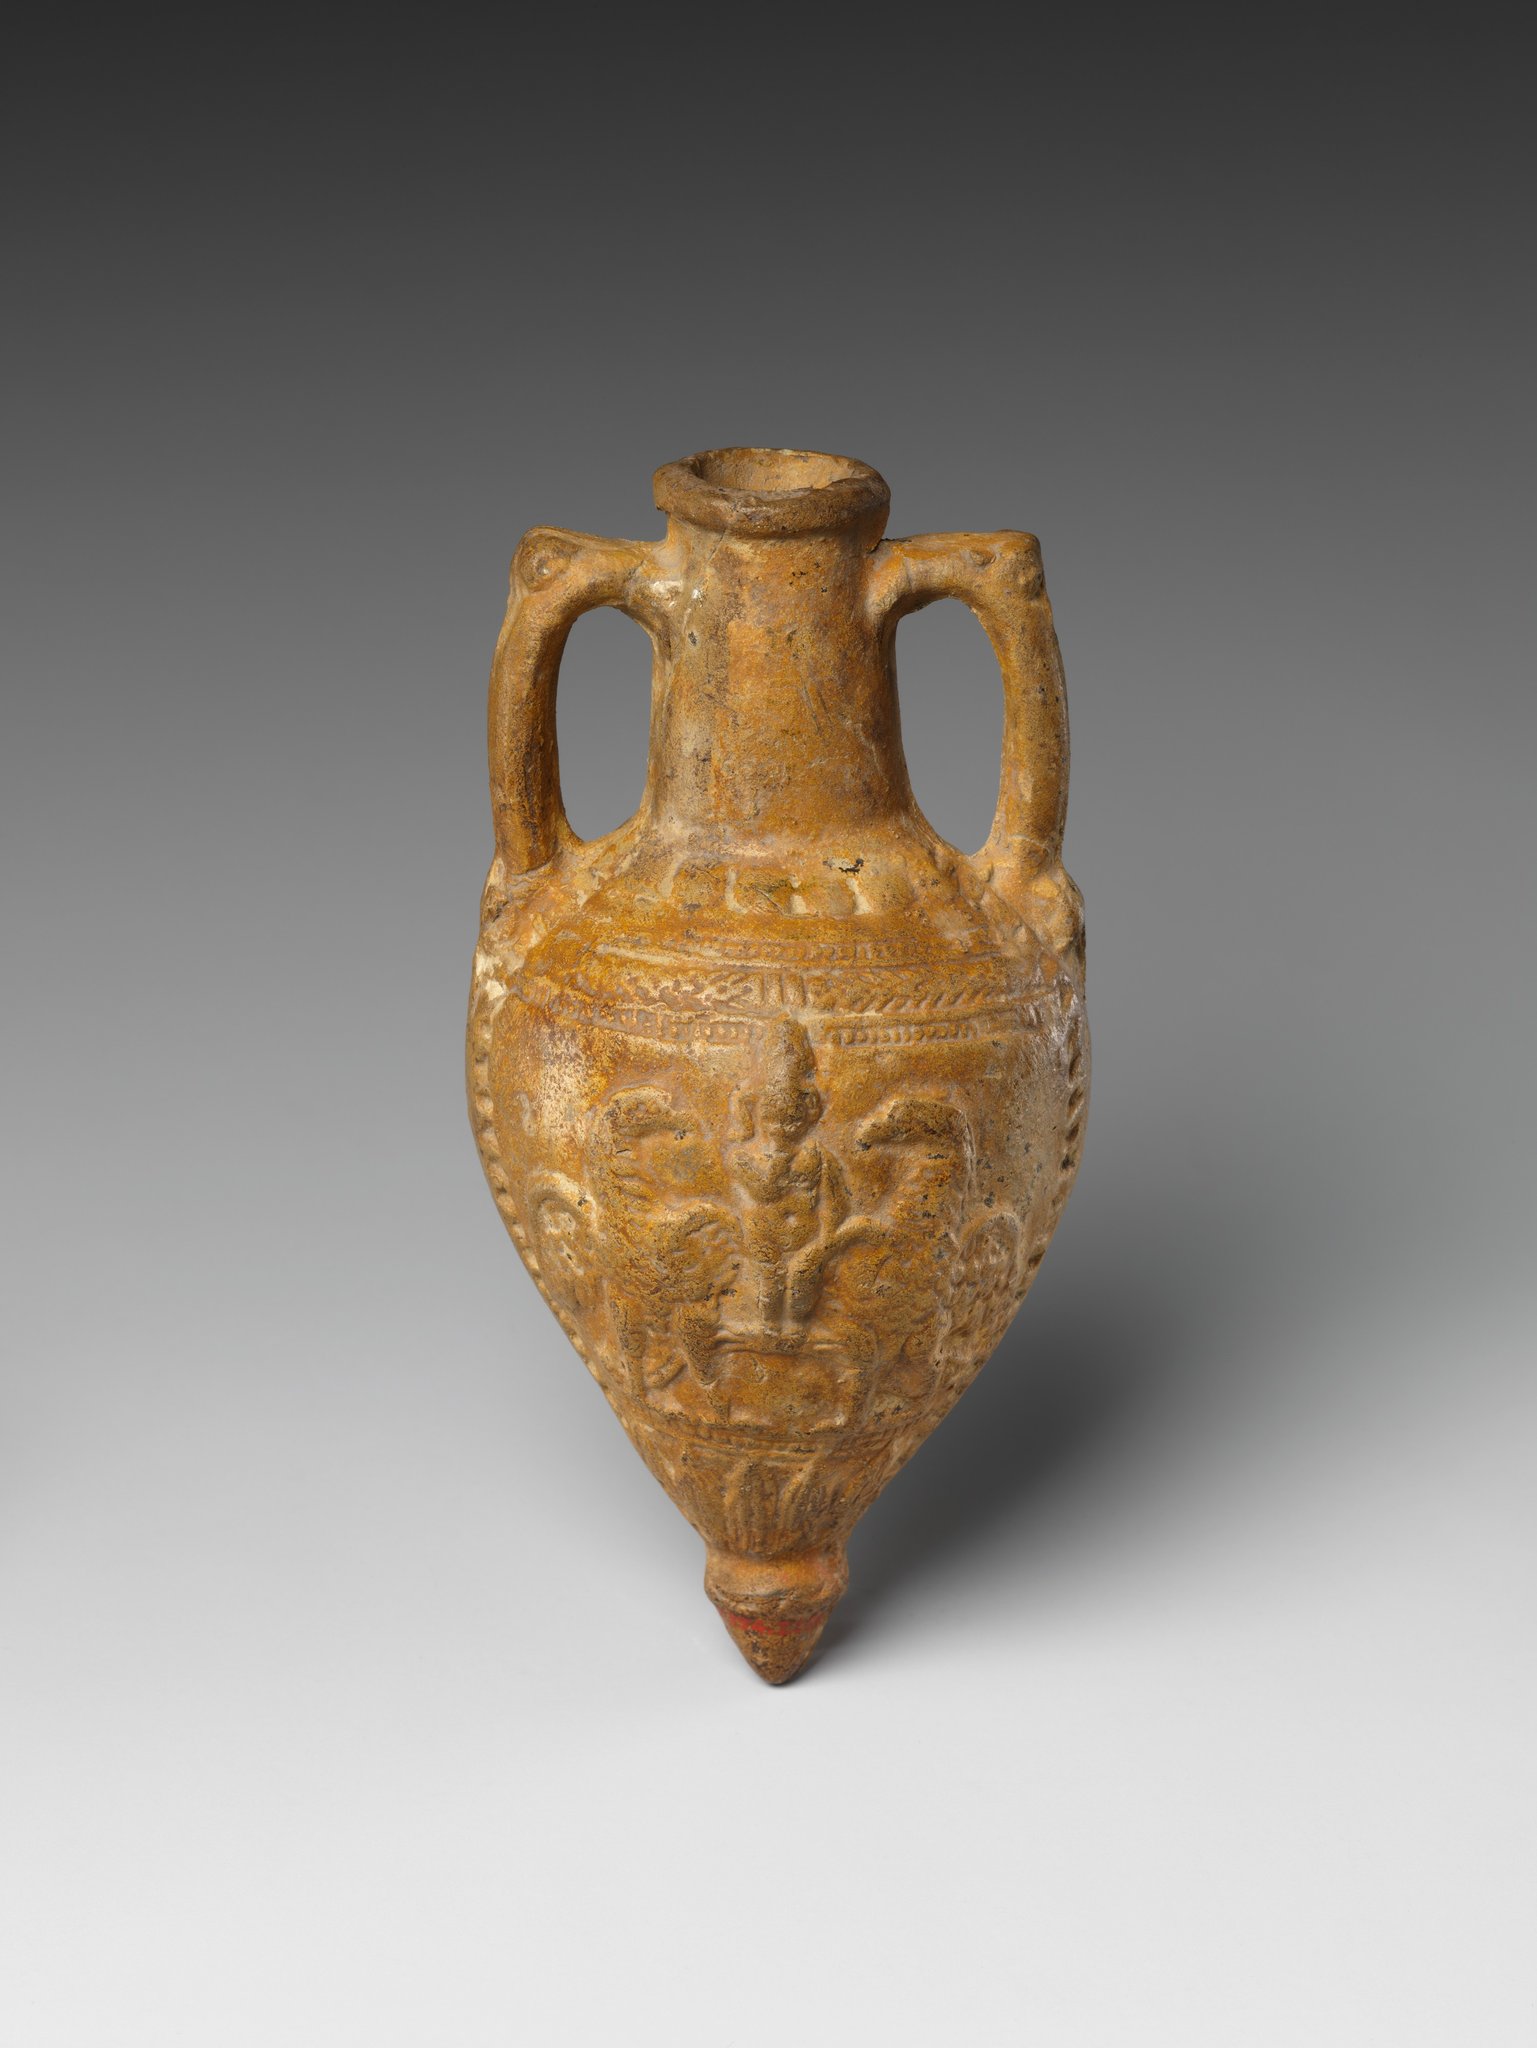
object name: jar, amphoriskos, relief figure, harpokrates, eagle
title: Amphoriskos with molded design of Harpokrates and eagles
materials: pottery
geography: egypt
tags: eagles,horus